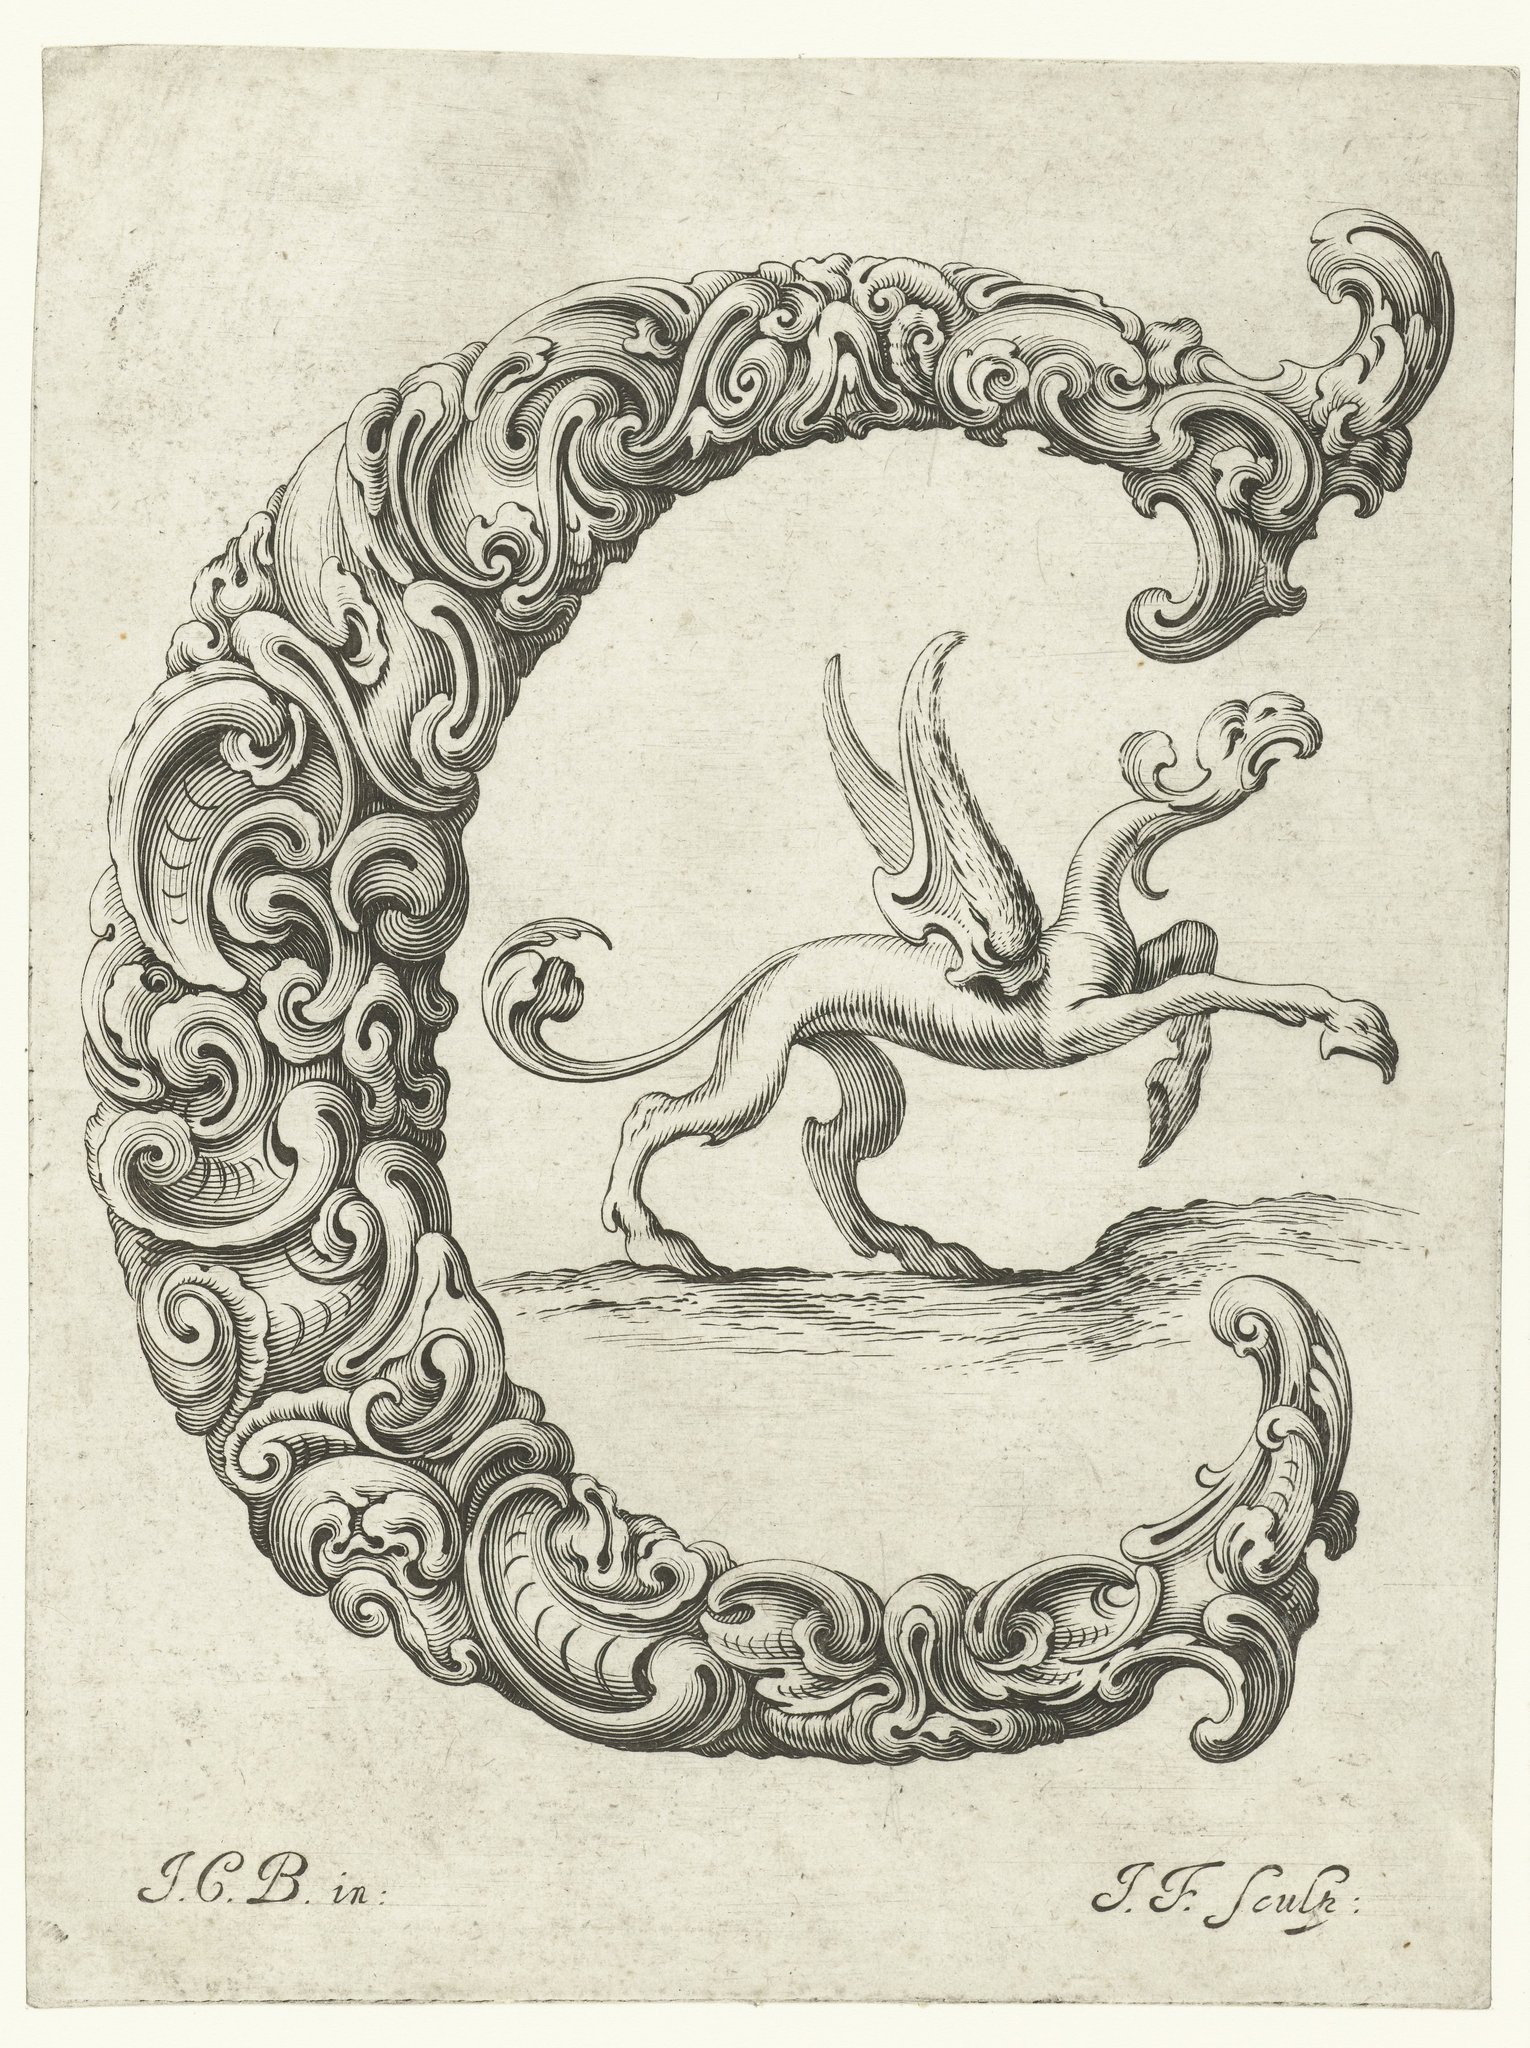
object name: ornament print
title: Libellus Novus Elementorum Latinorum Cum AEneis picturis usui Aurifabrorum inservientib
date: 1645-1650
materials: paper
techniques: engraving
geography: germany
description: In het midden staat een soort griffioen. Blad met de letter C uit serie van 26 bladen met letters uit het alfabet.